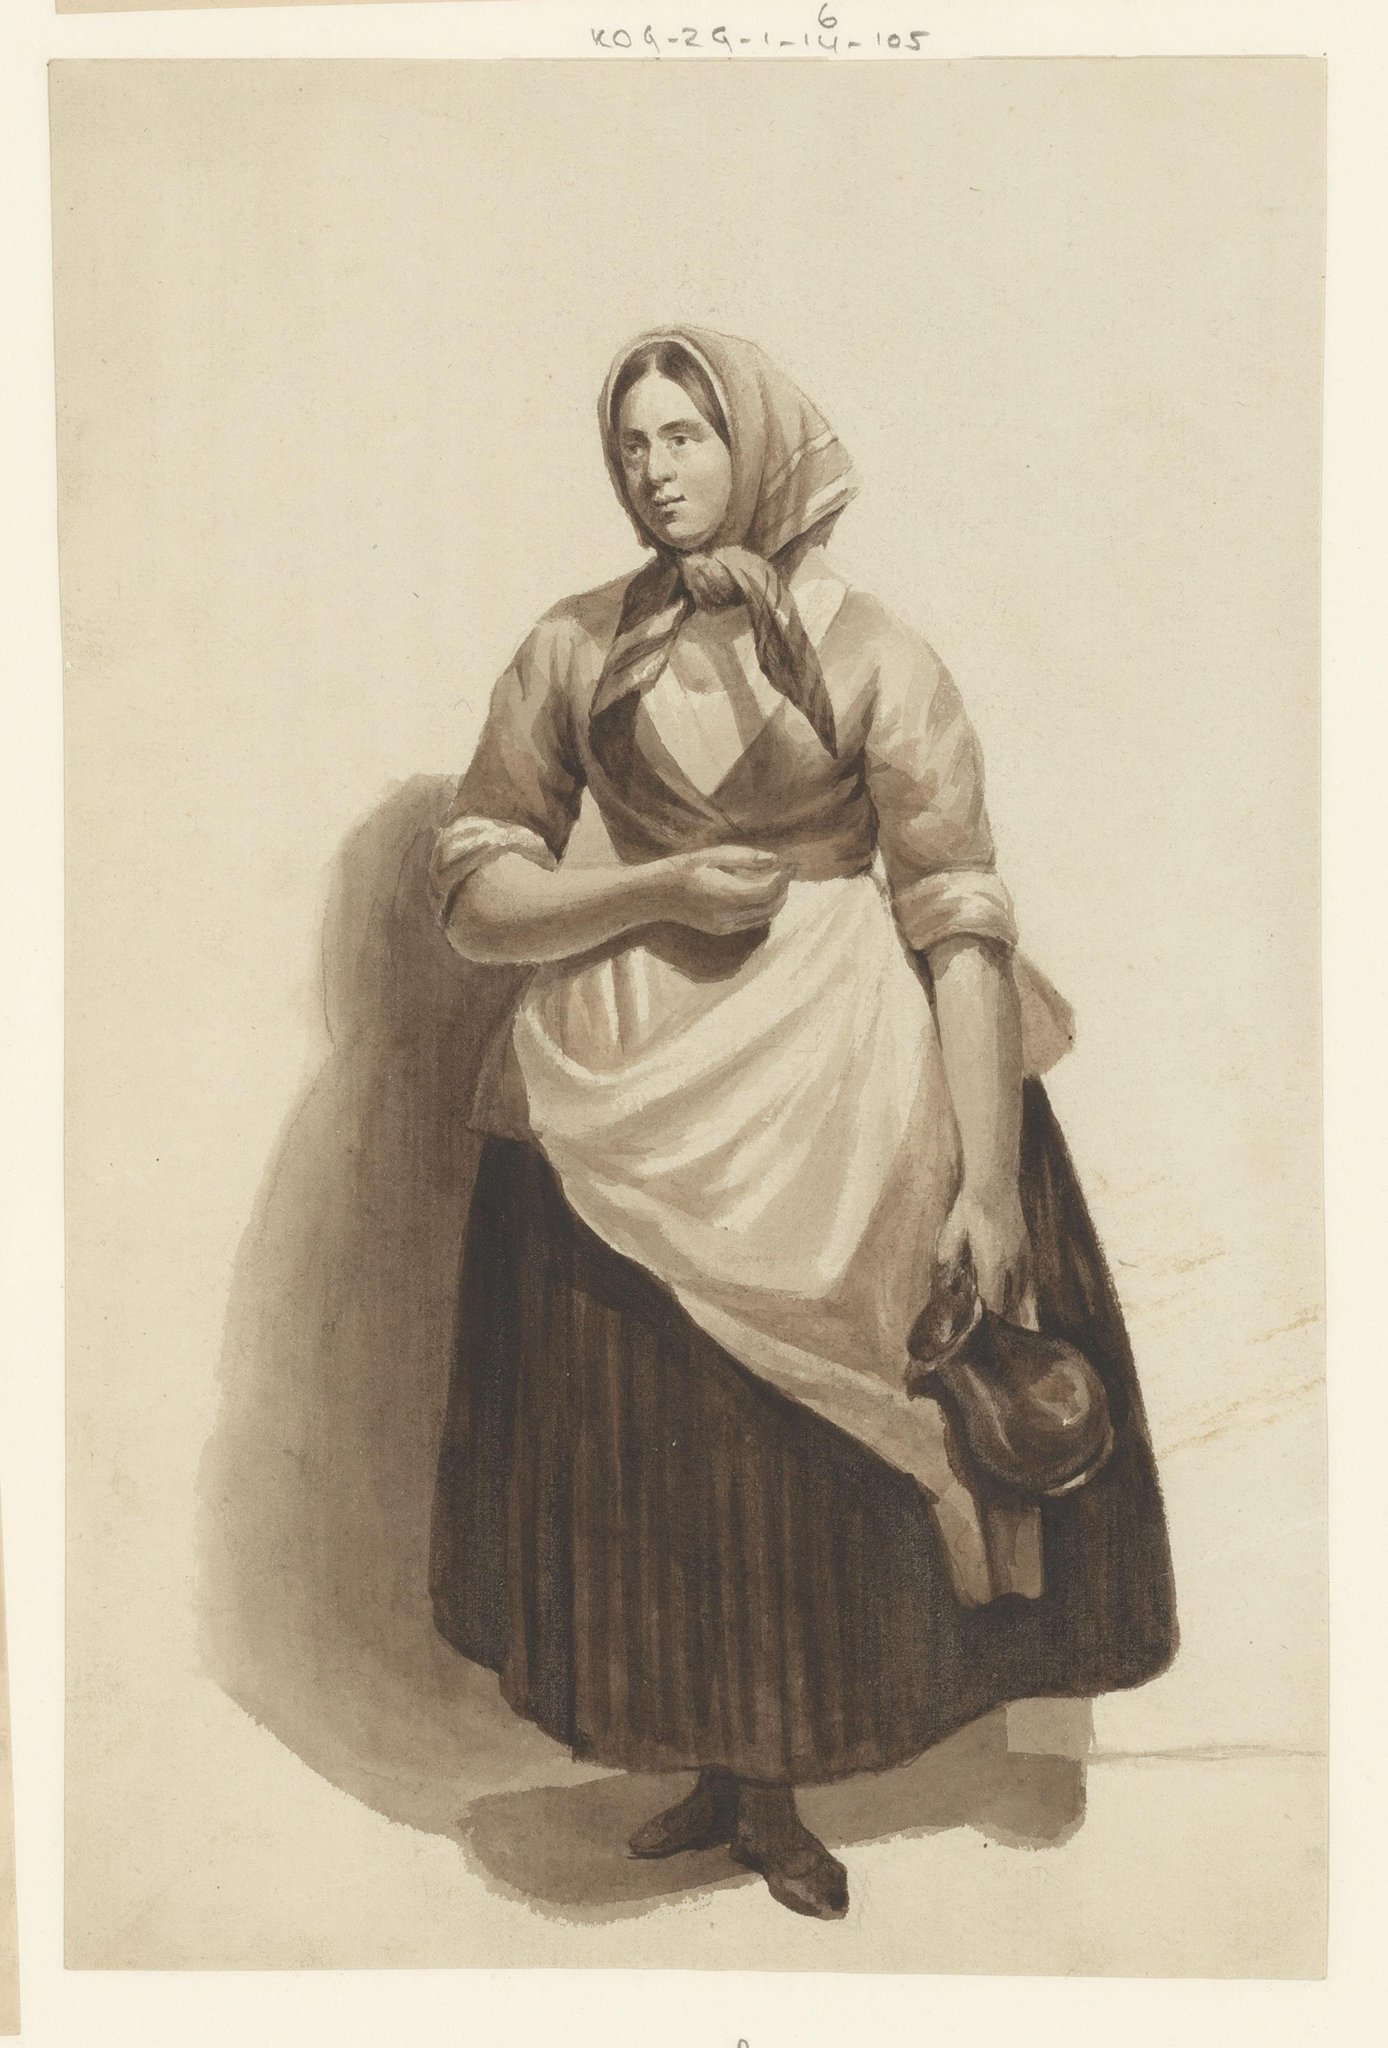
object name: drawing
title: Staande vrouw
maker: Anonymous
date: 1800-1850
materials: ink, paper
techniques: brush, pen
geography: netherlands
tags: standing figure - aa - female human figure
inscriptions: collector's mark, collector's mark: Lugt 1641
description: Een staande vrouw met hoofddoek en kan in de hand. Onderwerpsrubrieken binnen de Atlas Zeden en Gewoonten: Beroep en bedrijf. Vrouwelijk beroep en bedrijf. Dienstboden.